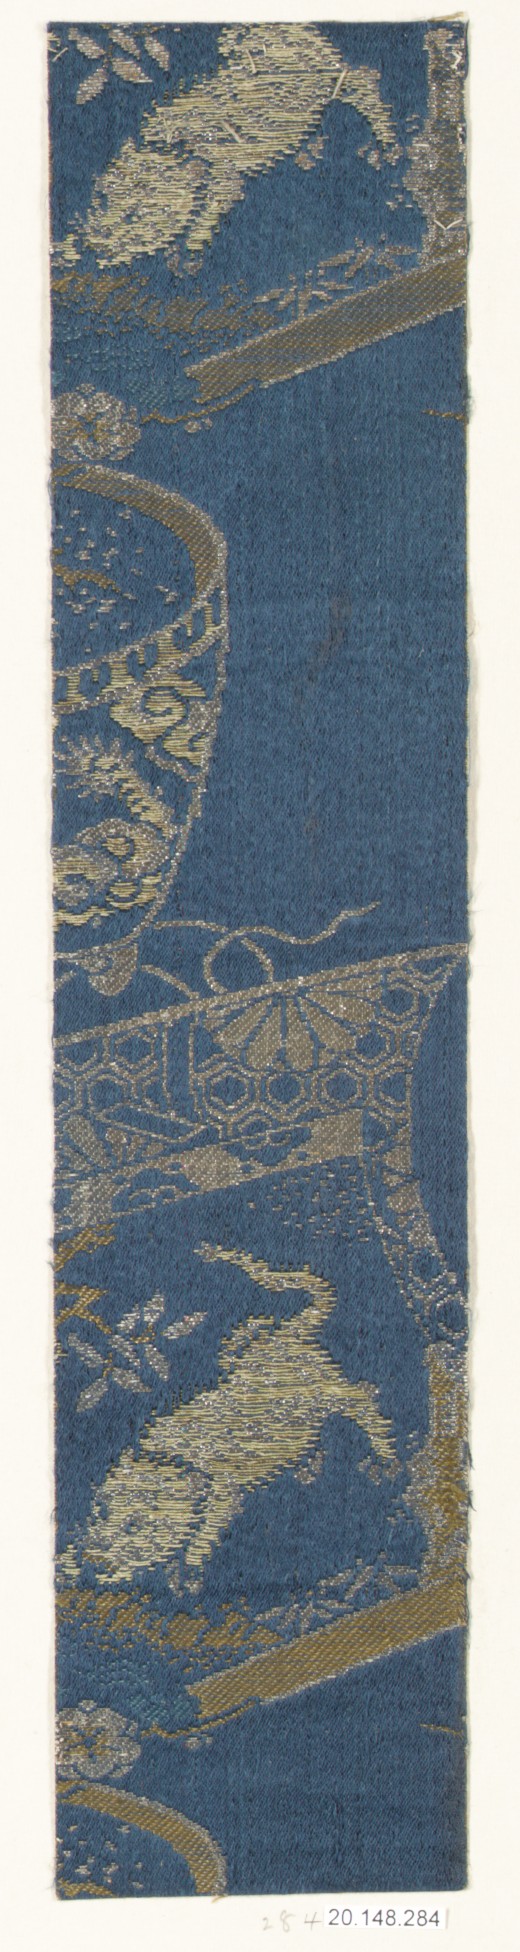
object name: piece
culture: japanese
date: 1701-1800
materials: silk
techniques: compound weave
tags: dogs,flowers